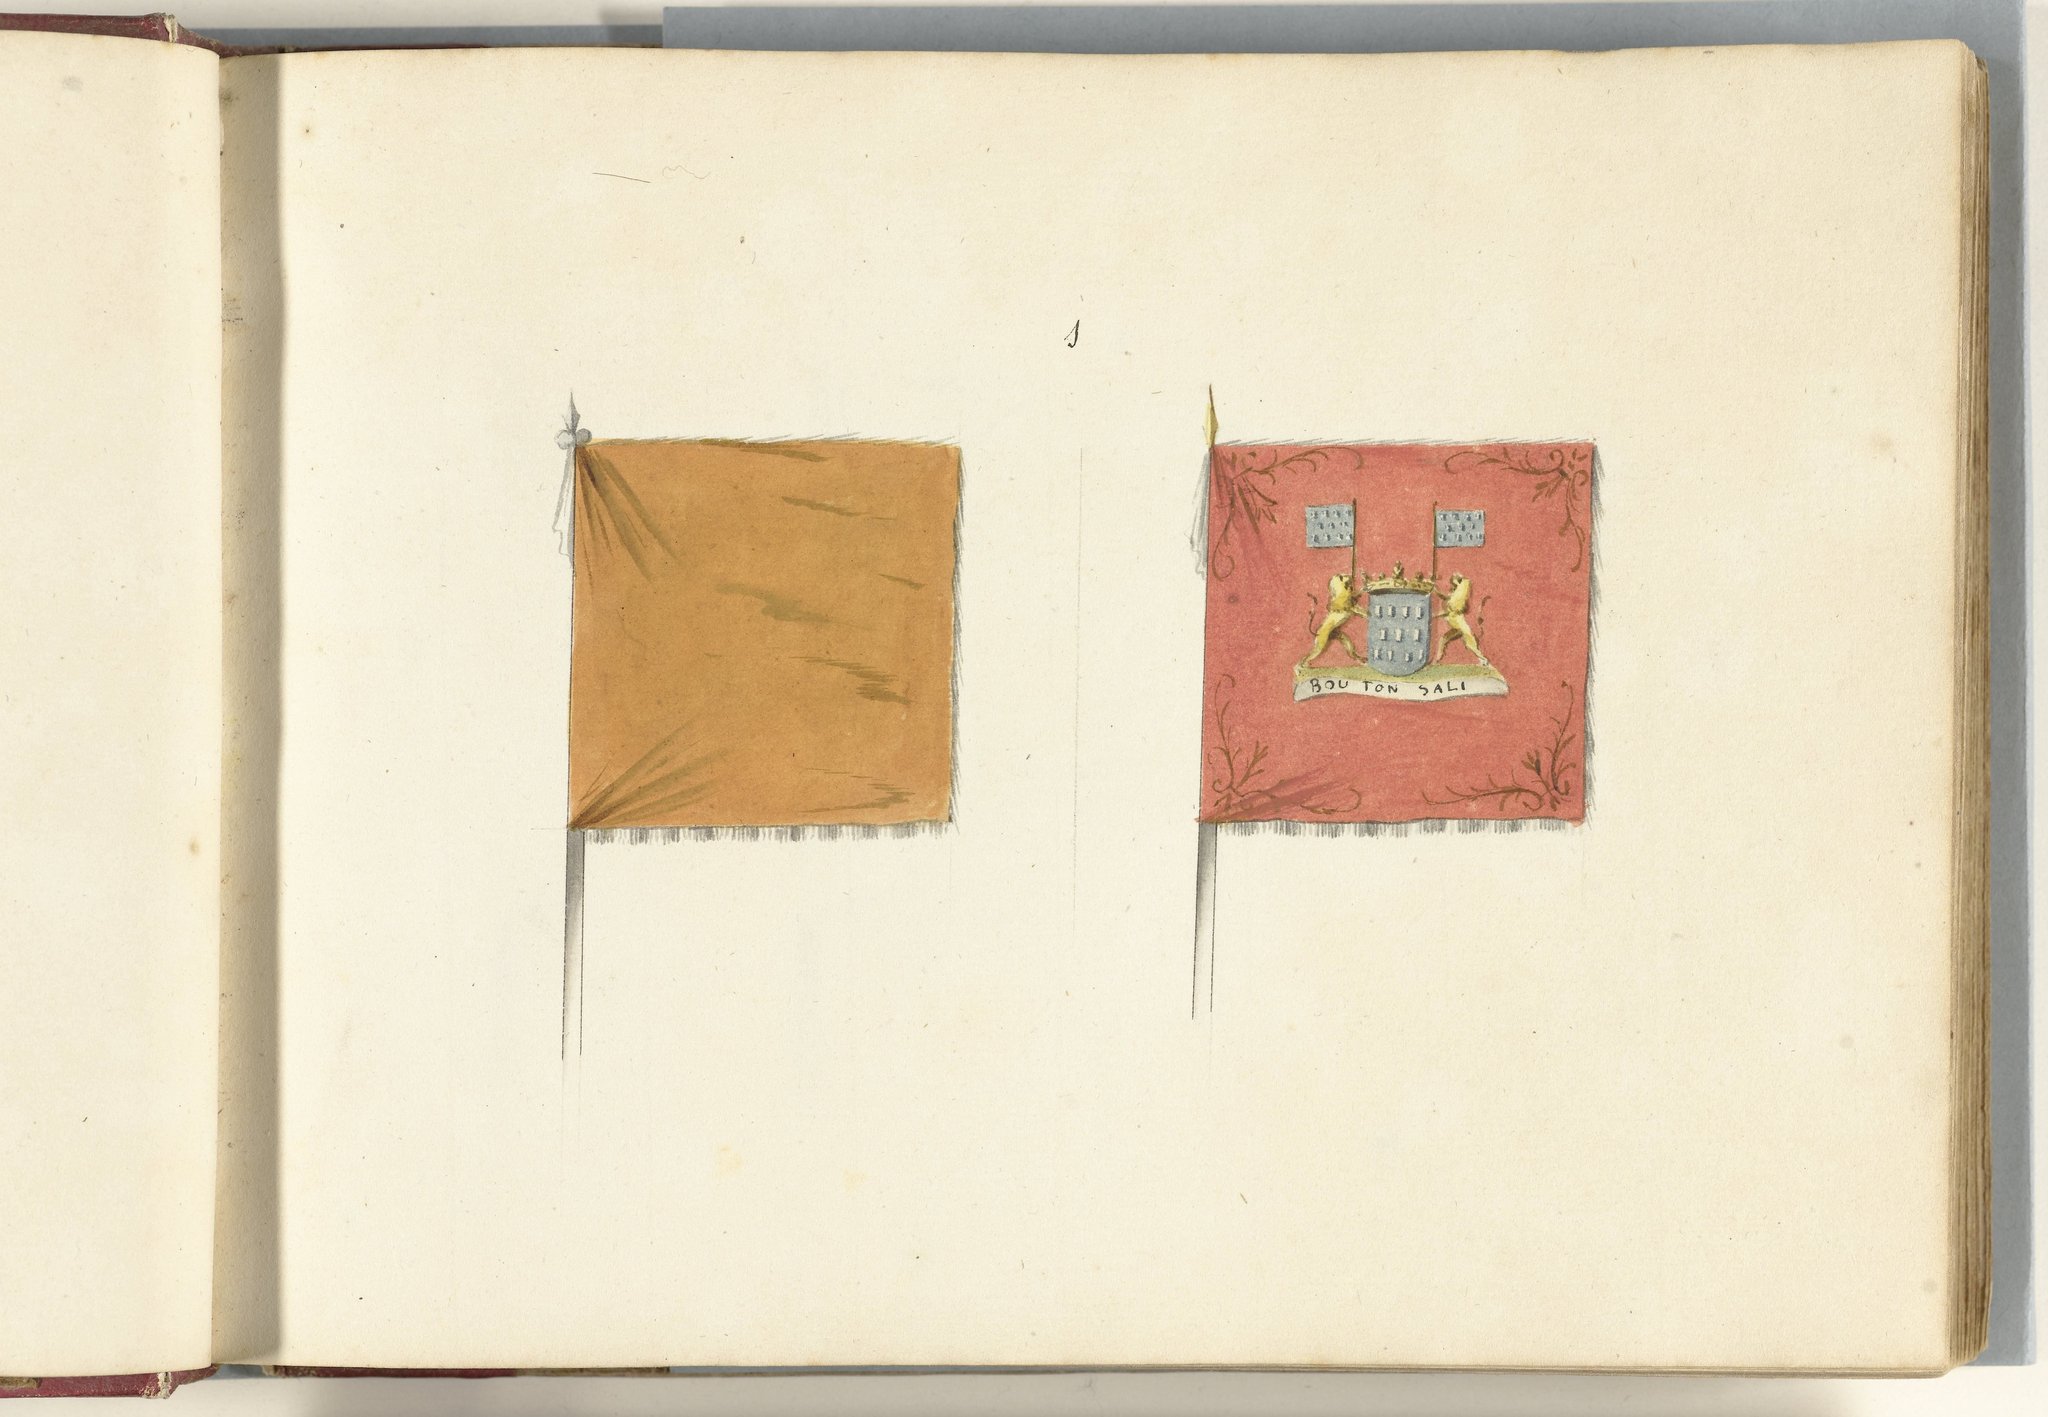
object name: drawing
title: Twee Franse vaandels veroverd in de slag bij Spierbach, 1703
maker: Anonymous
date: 1713-1720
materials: paper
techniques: drawing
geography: northern netherlands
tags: (military) flags and standards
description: Twee Franse vaandels veroverd in de slag bij Spierbach, 1703. In het boek met tekeningen van Franse vaandels, standaarden en pauken, veroverd tijdens de Spaanse Successieoorlog (1701-1713).